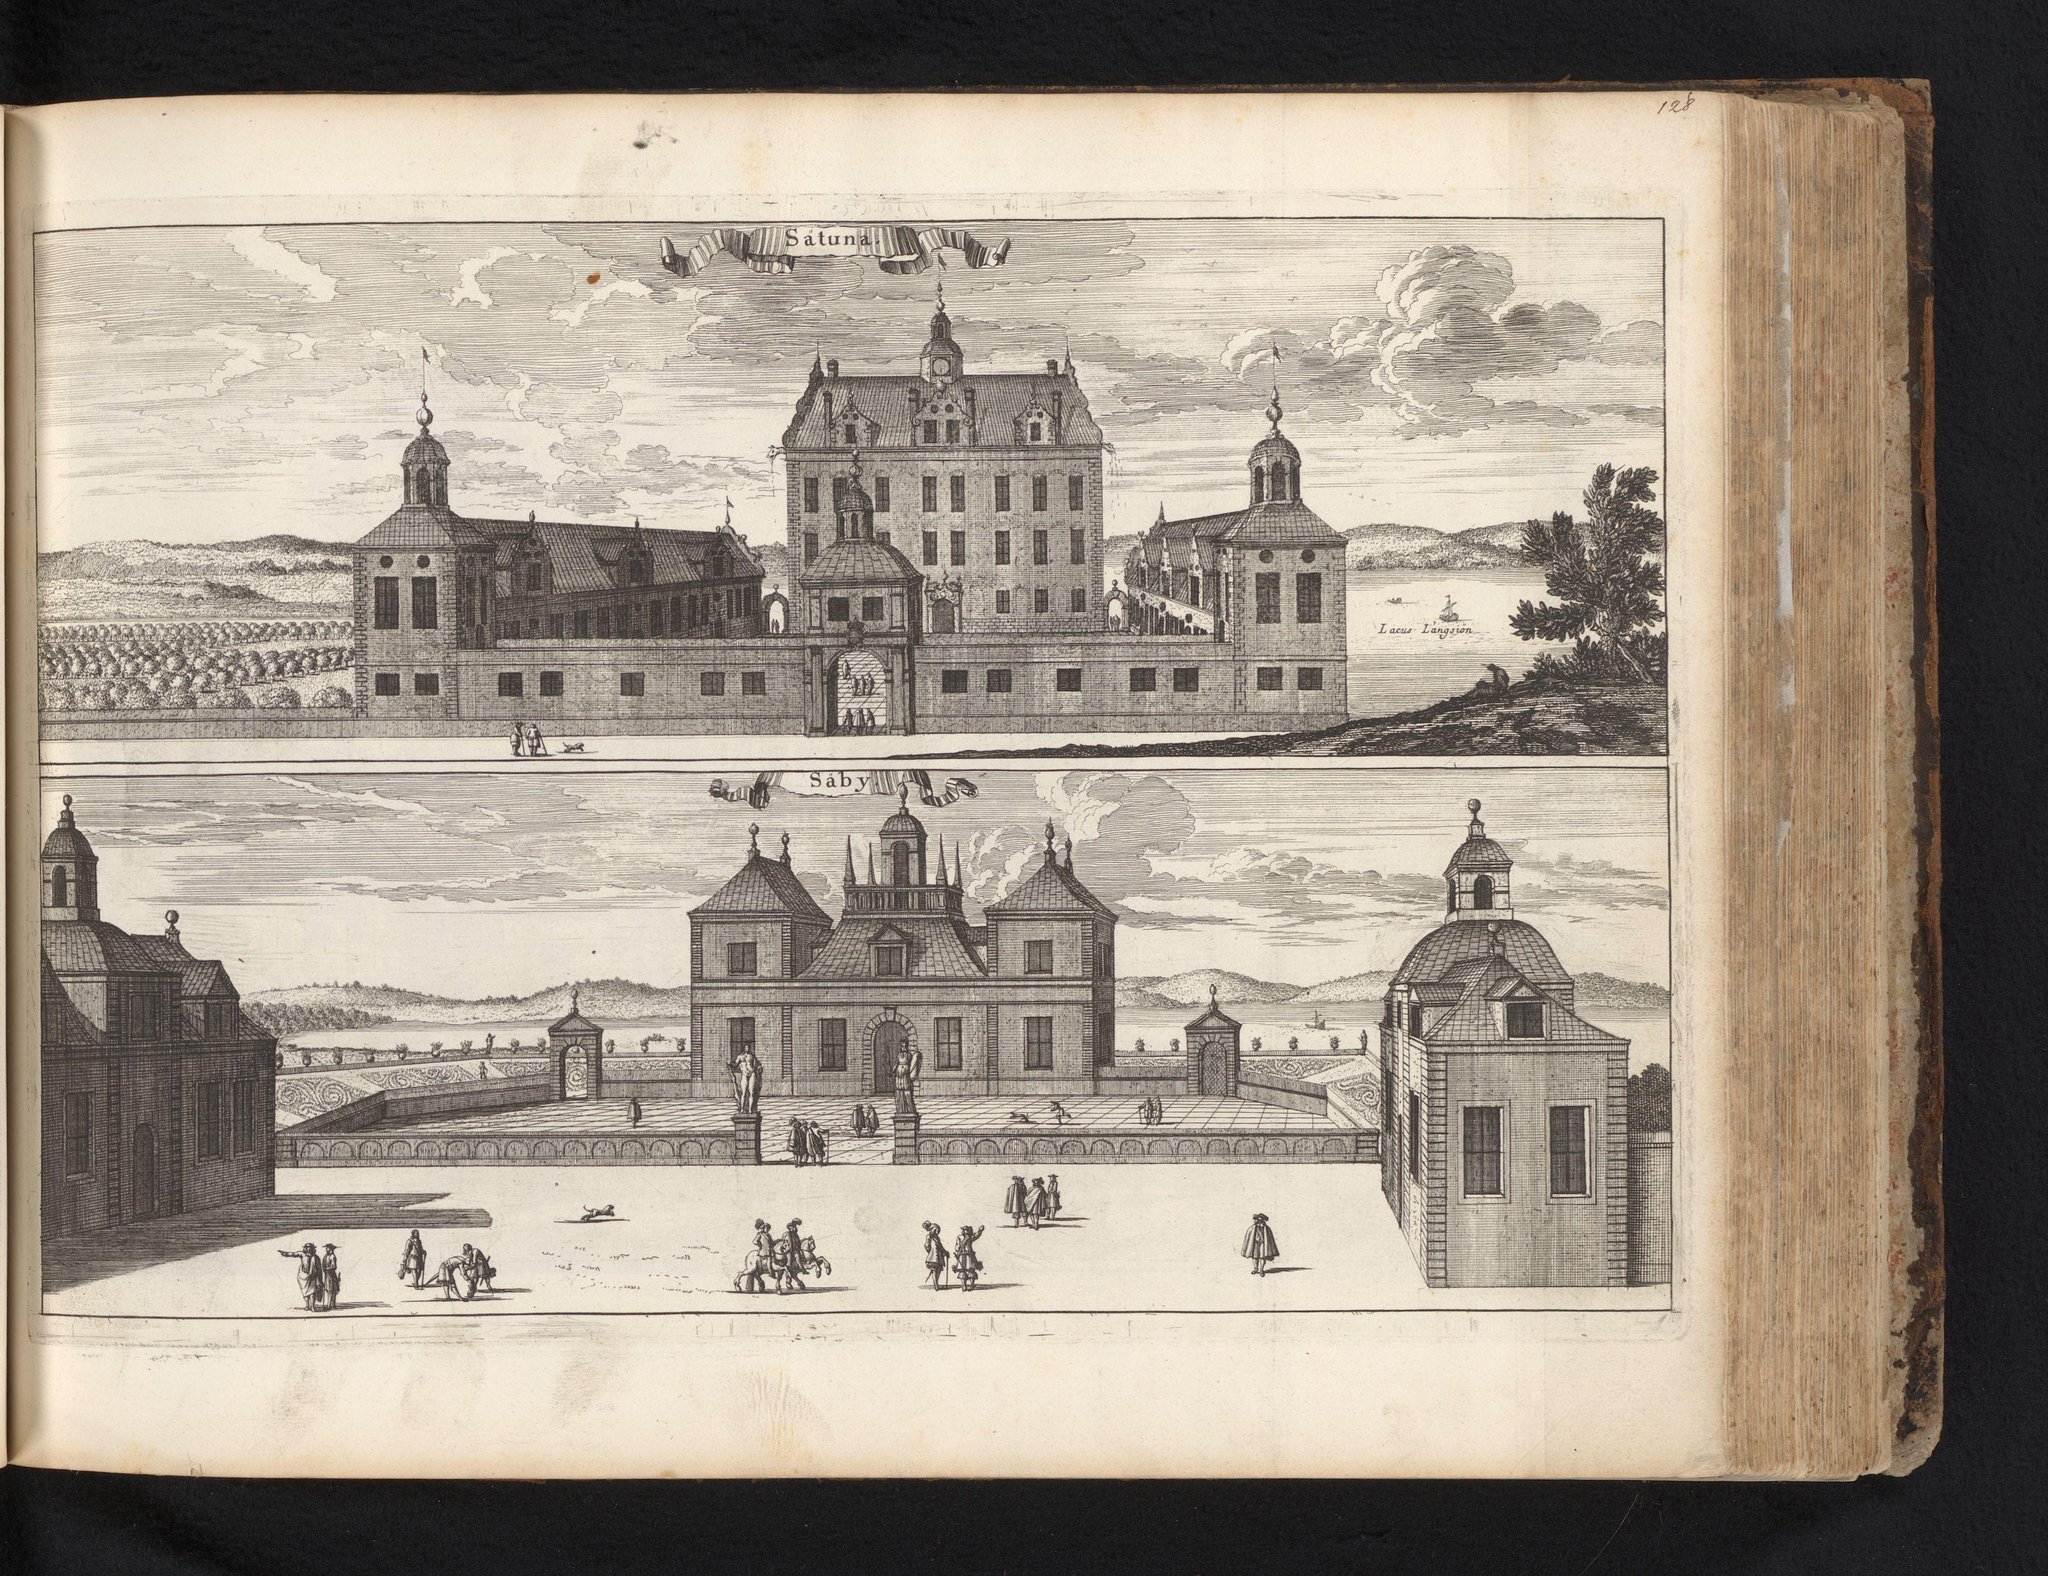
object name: album leaf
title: Suecia Antiqua et Hodierna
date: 1670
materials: paper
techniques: etching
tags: housing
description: Kungliga Biblioteket, 'Suecia': http://www.kb.se/samlingarna/Kartor-bilder/Suecia-antiqua/ (geraadpleegd november 2016).